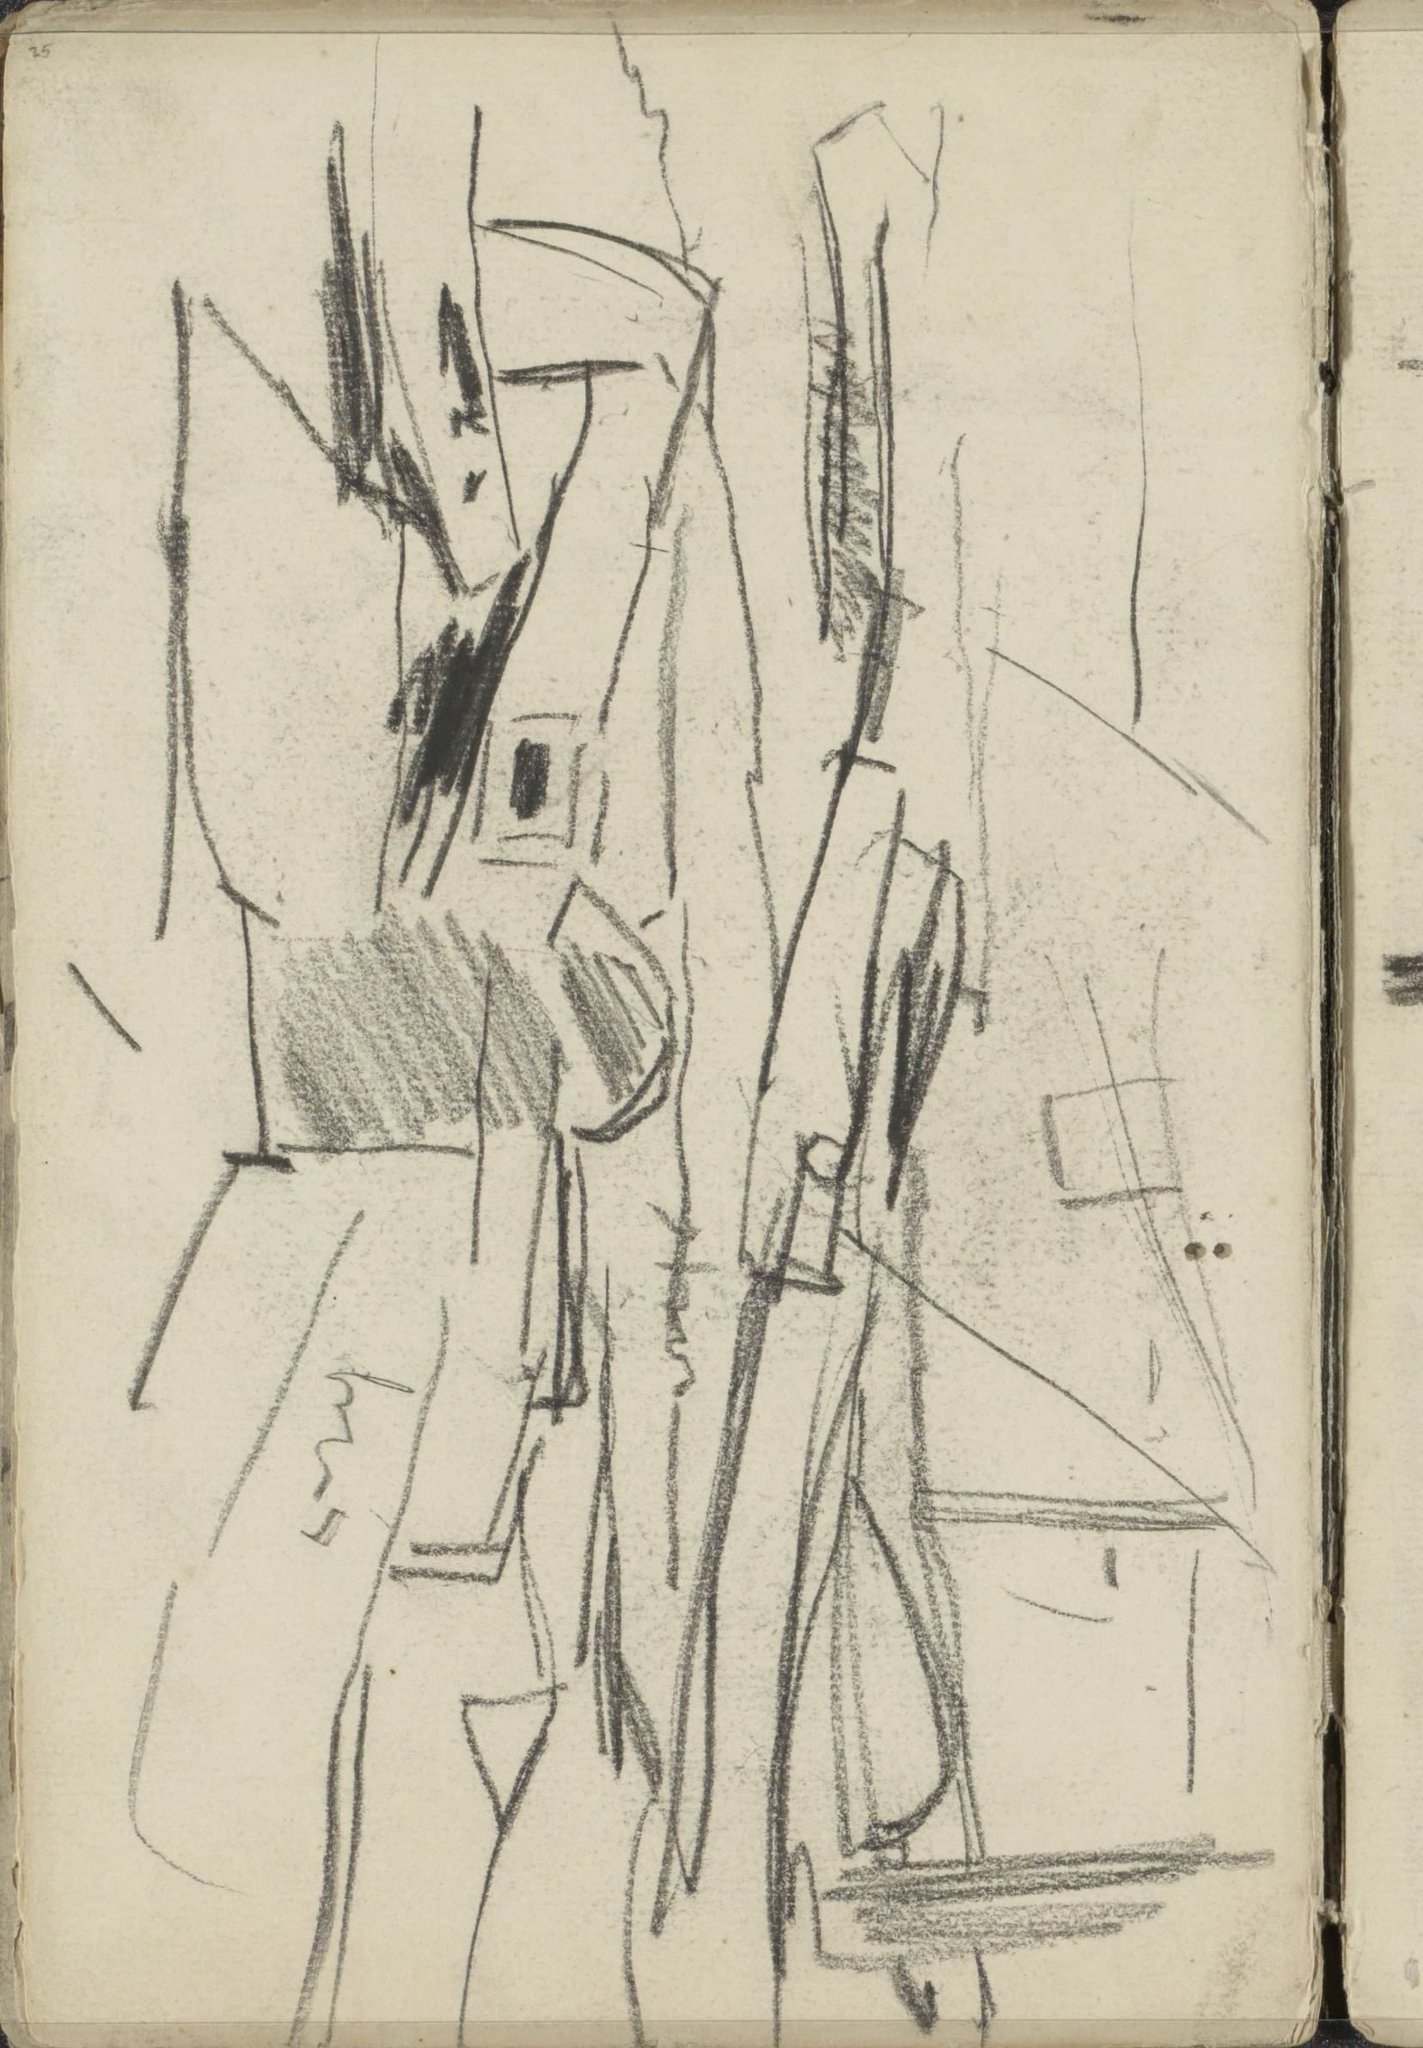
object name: sketchbook leaf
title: Studie, mogelijk van aangemeerde boten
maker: george hendrik breitner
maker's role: draughtsman, painter, print maker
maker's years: 1857-1923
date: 1887-1891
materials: chalk, paper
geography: amsterdam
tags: harbour, ships (in general)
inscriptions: kleurnotitie, handgeschreven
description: Pagina 25 uit een schetsboek met 17 bladen.